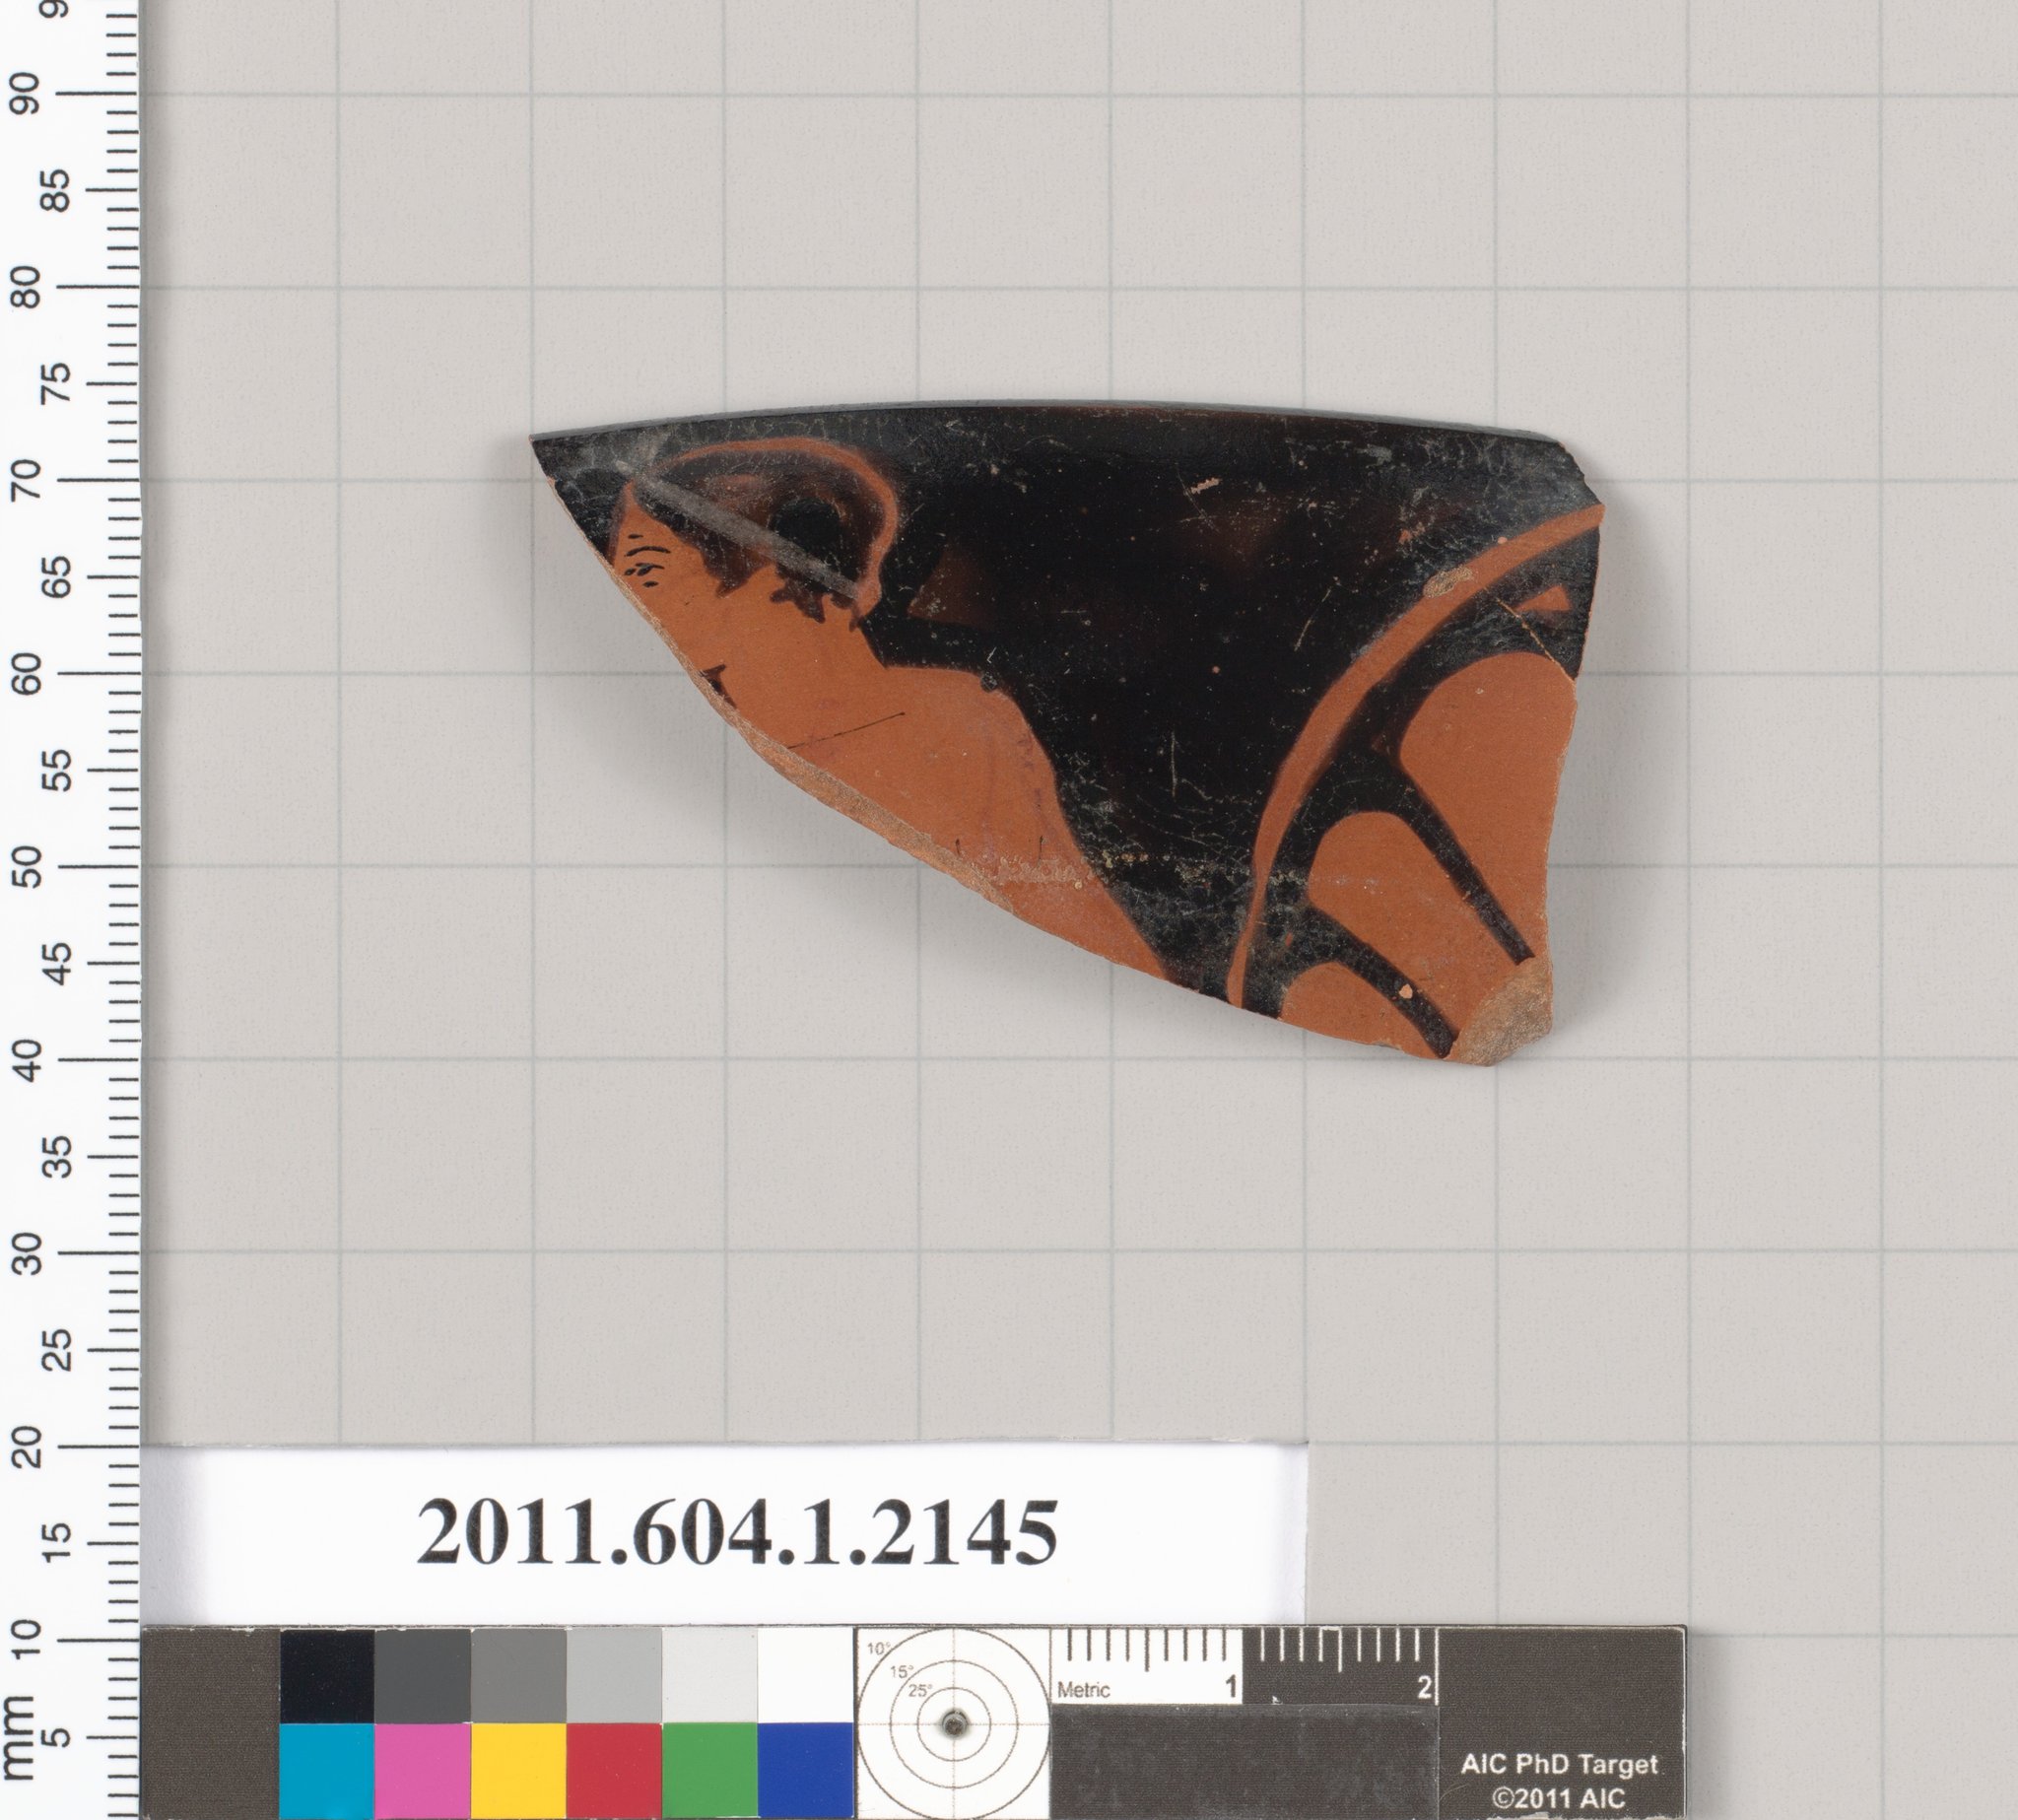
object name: kylix fragment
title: Terracotta rim fragment of a kylix (drinking cup)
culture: greek, attic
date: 467-435 BCE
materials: terracotta